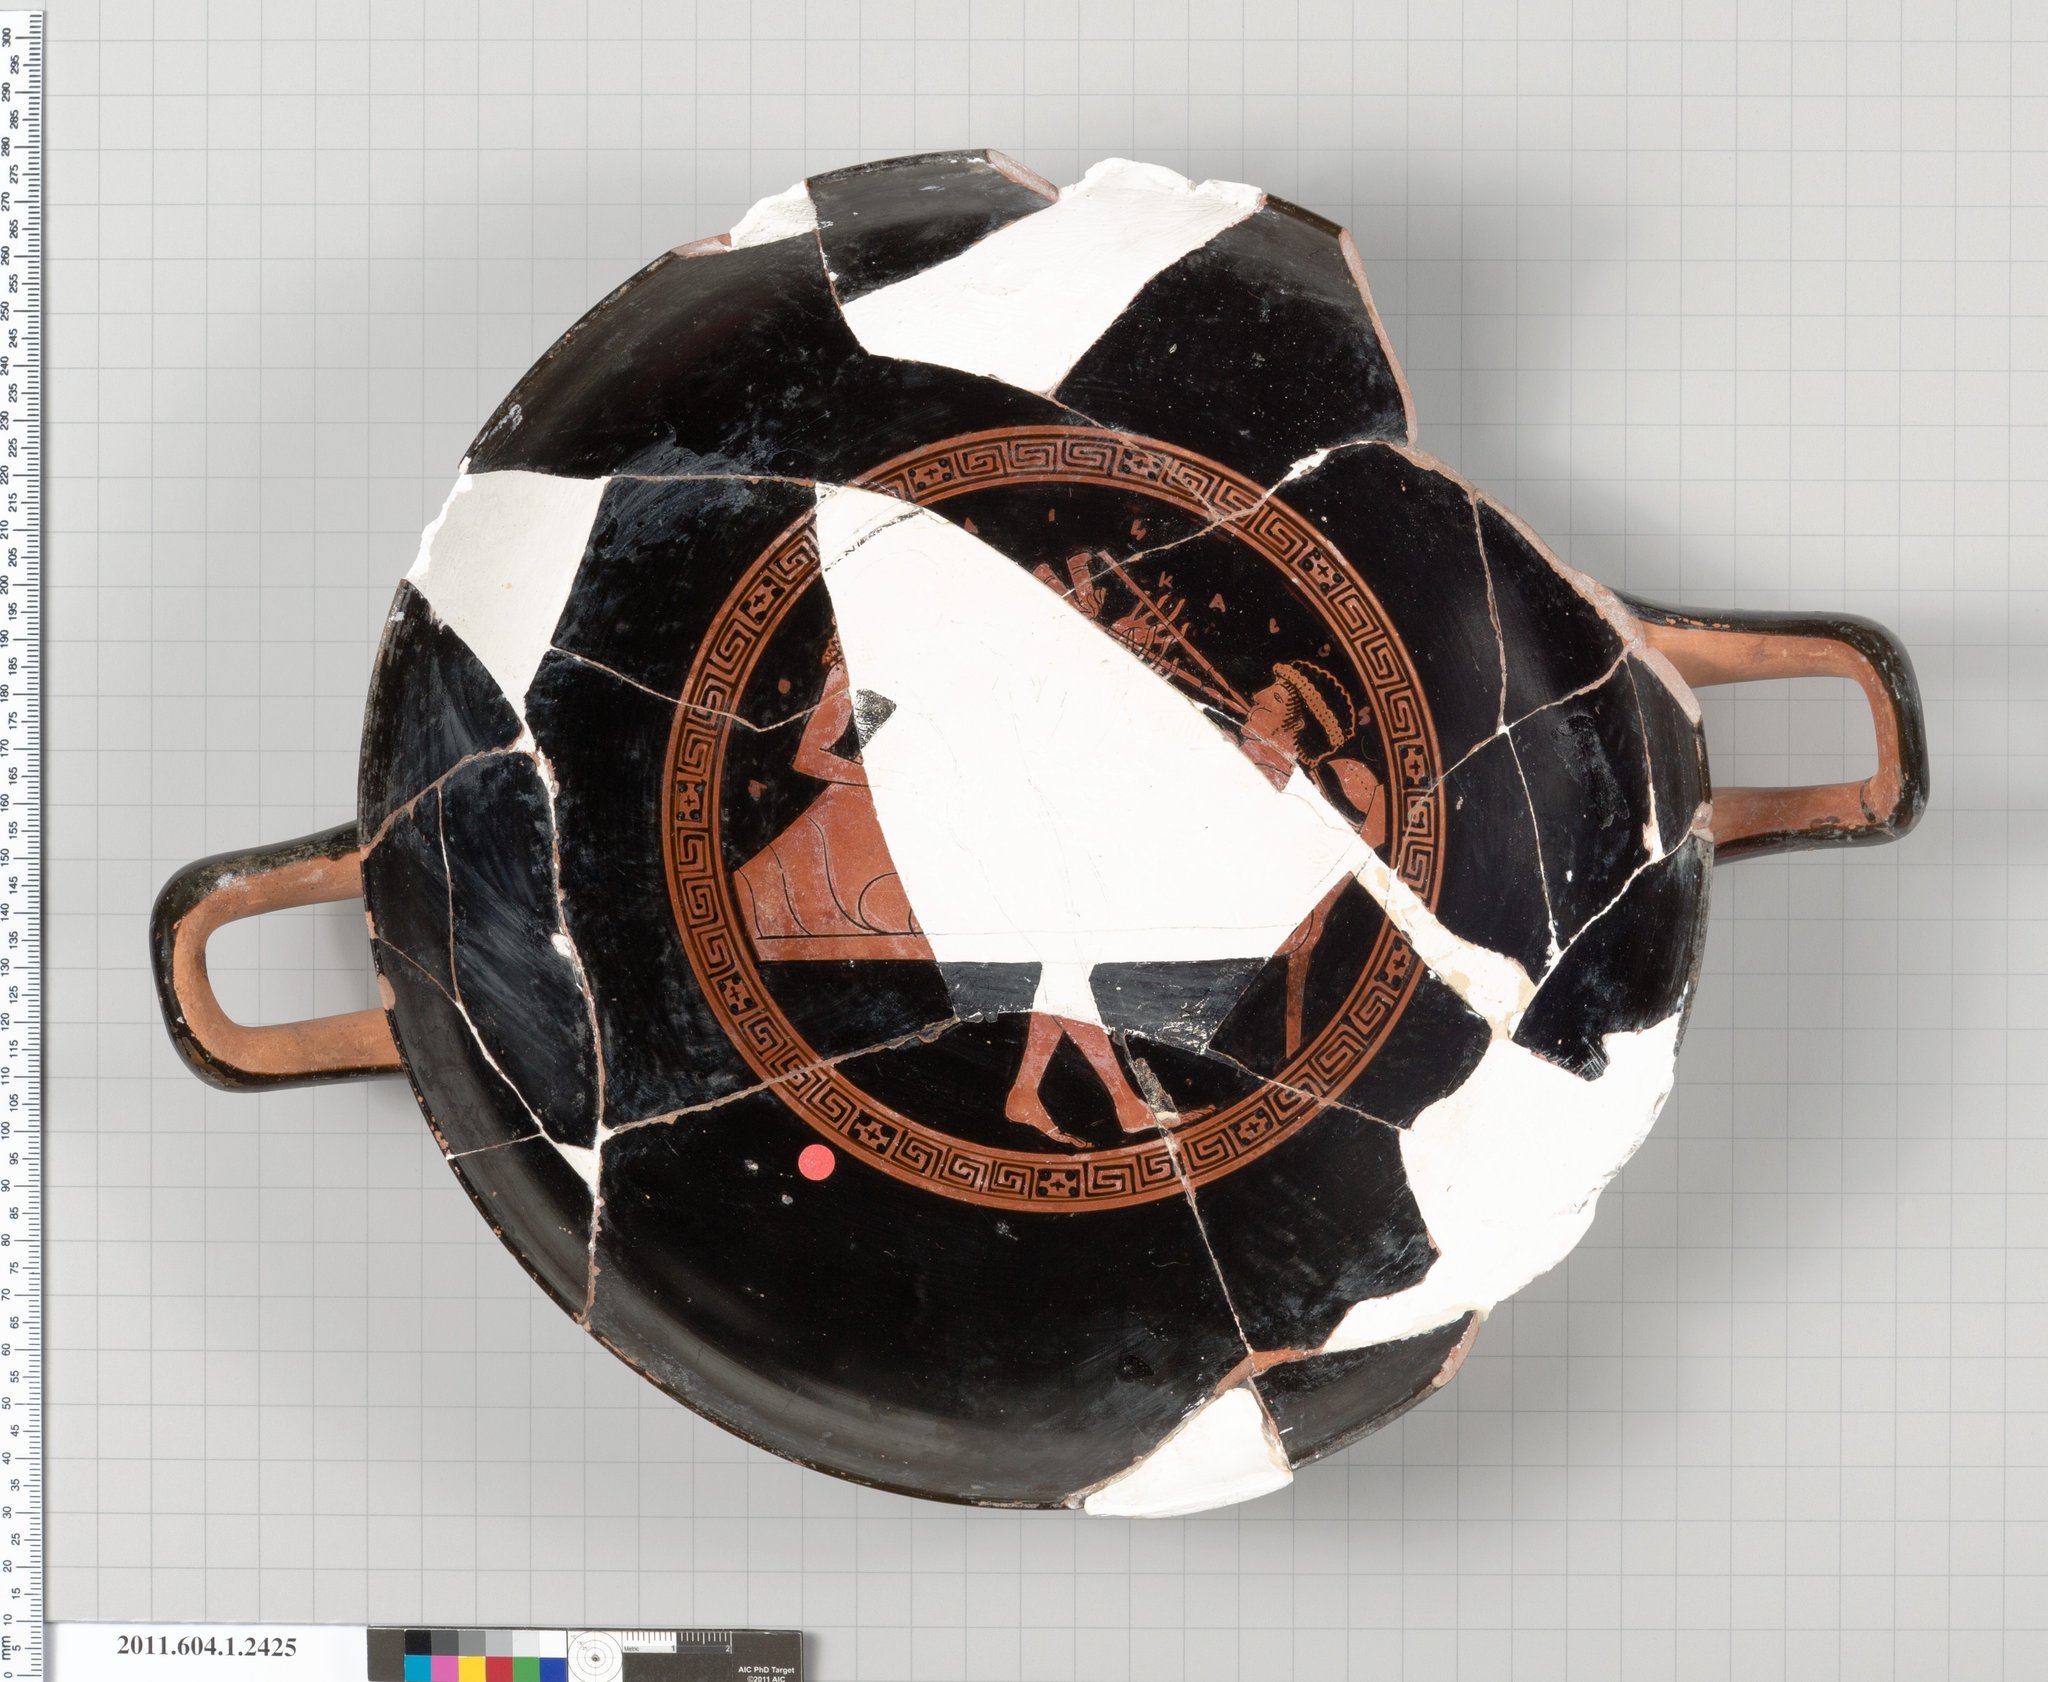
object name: kylix fragment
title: Terracotta fragment of a kylix (drinking cup)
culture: greek, attic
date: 490-480 BCE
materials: terracotta